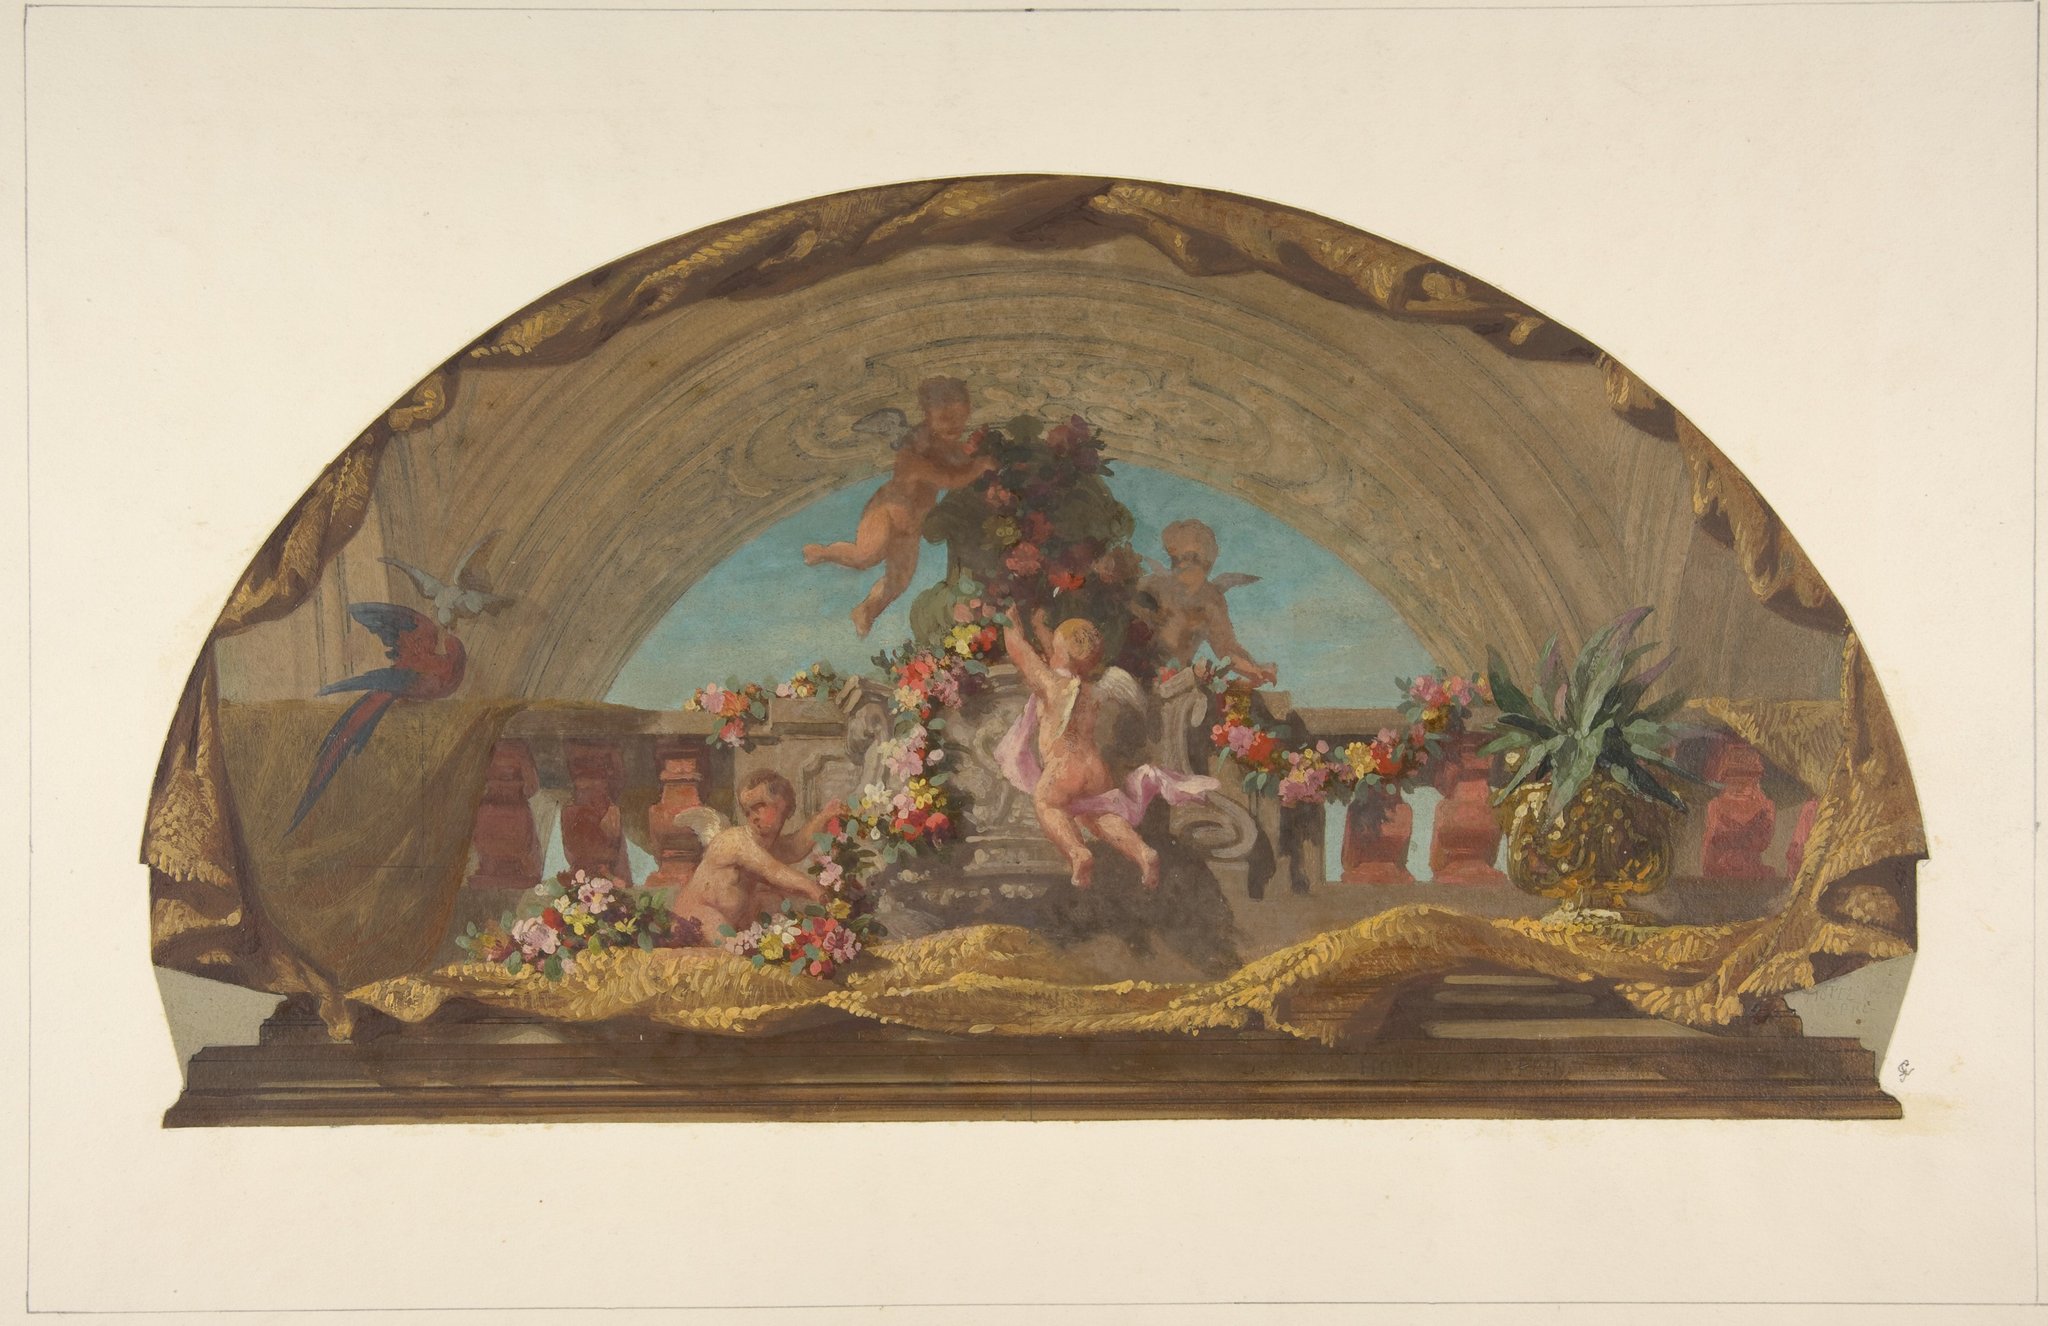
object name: drawing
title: Design for the Decoration of a Lunette on the Staircase, Hôtel de Pless, Berlin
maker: jules-edmond-charles lachaise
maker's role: artist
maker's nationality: french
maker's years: 1897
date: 1851-1900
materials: gouache, oil, paper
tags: garlands